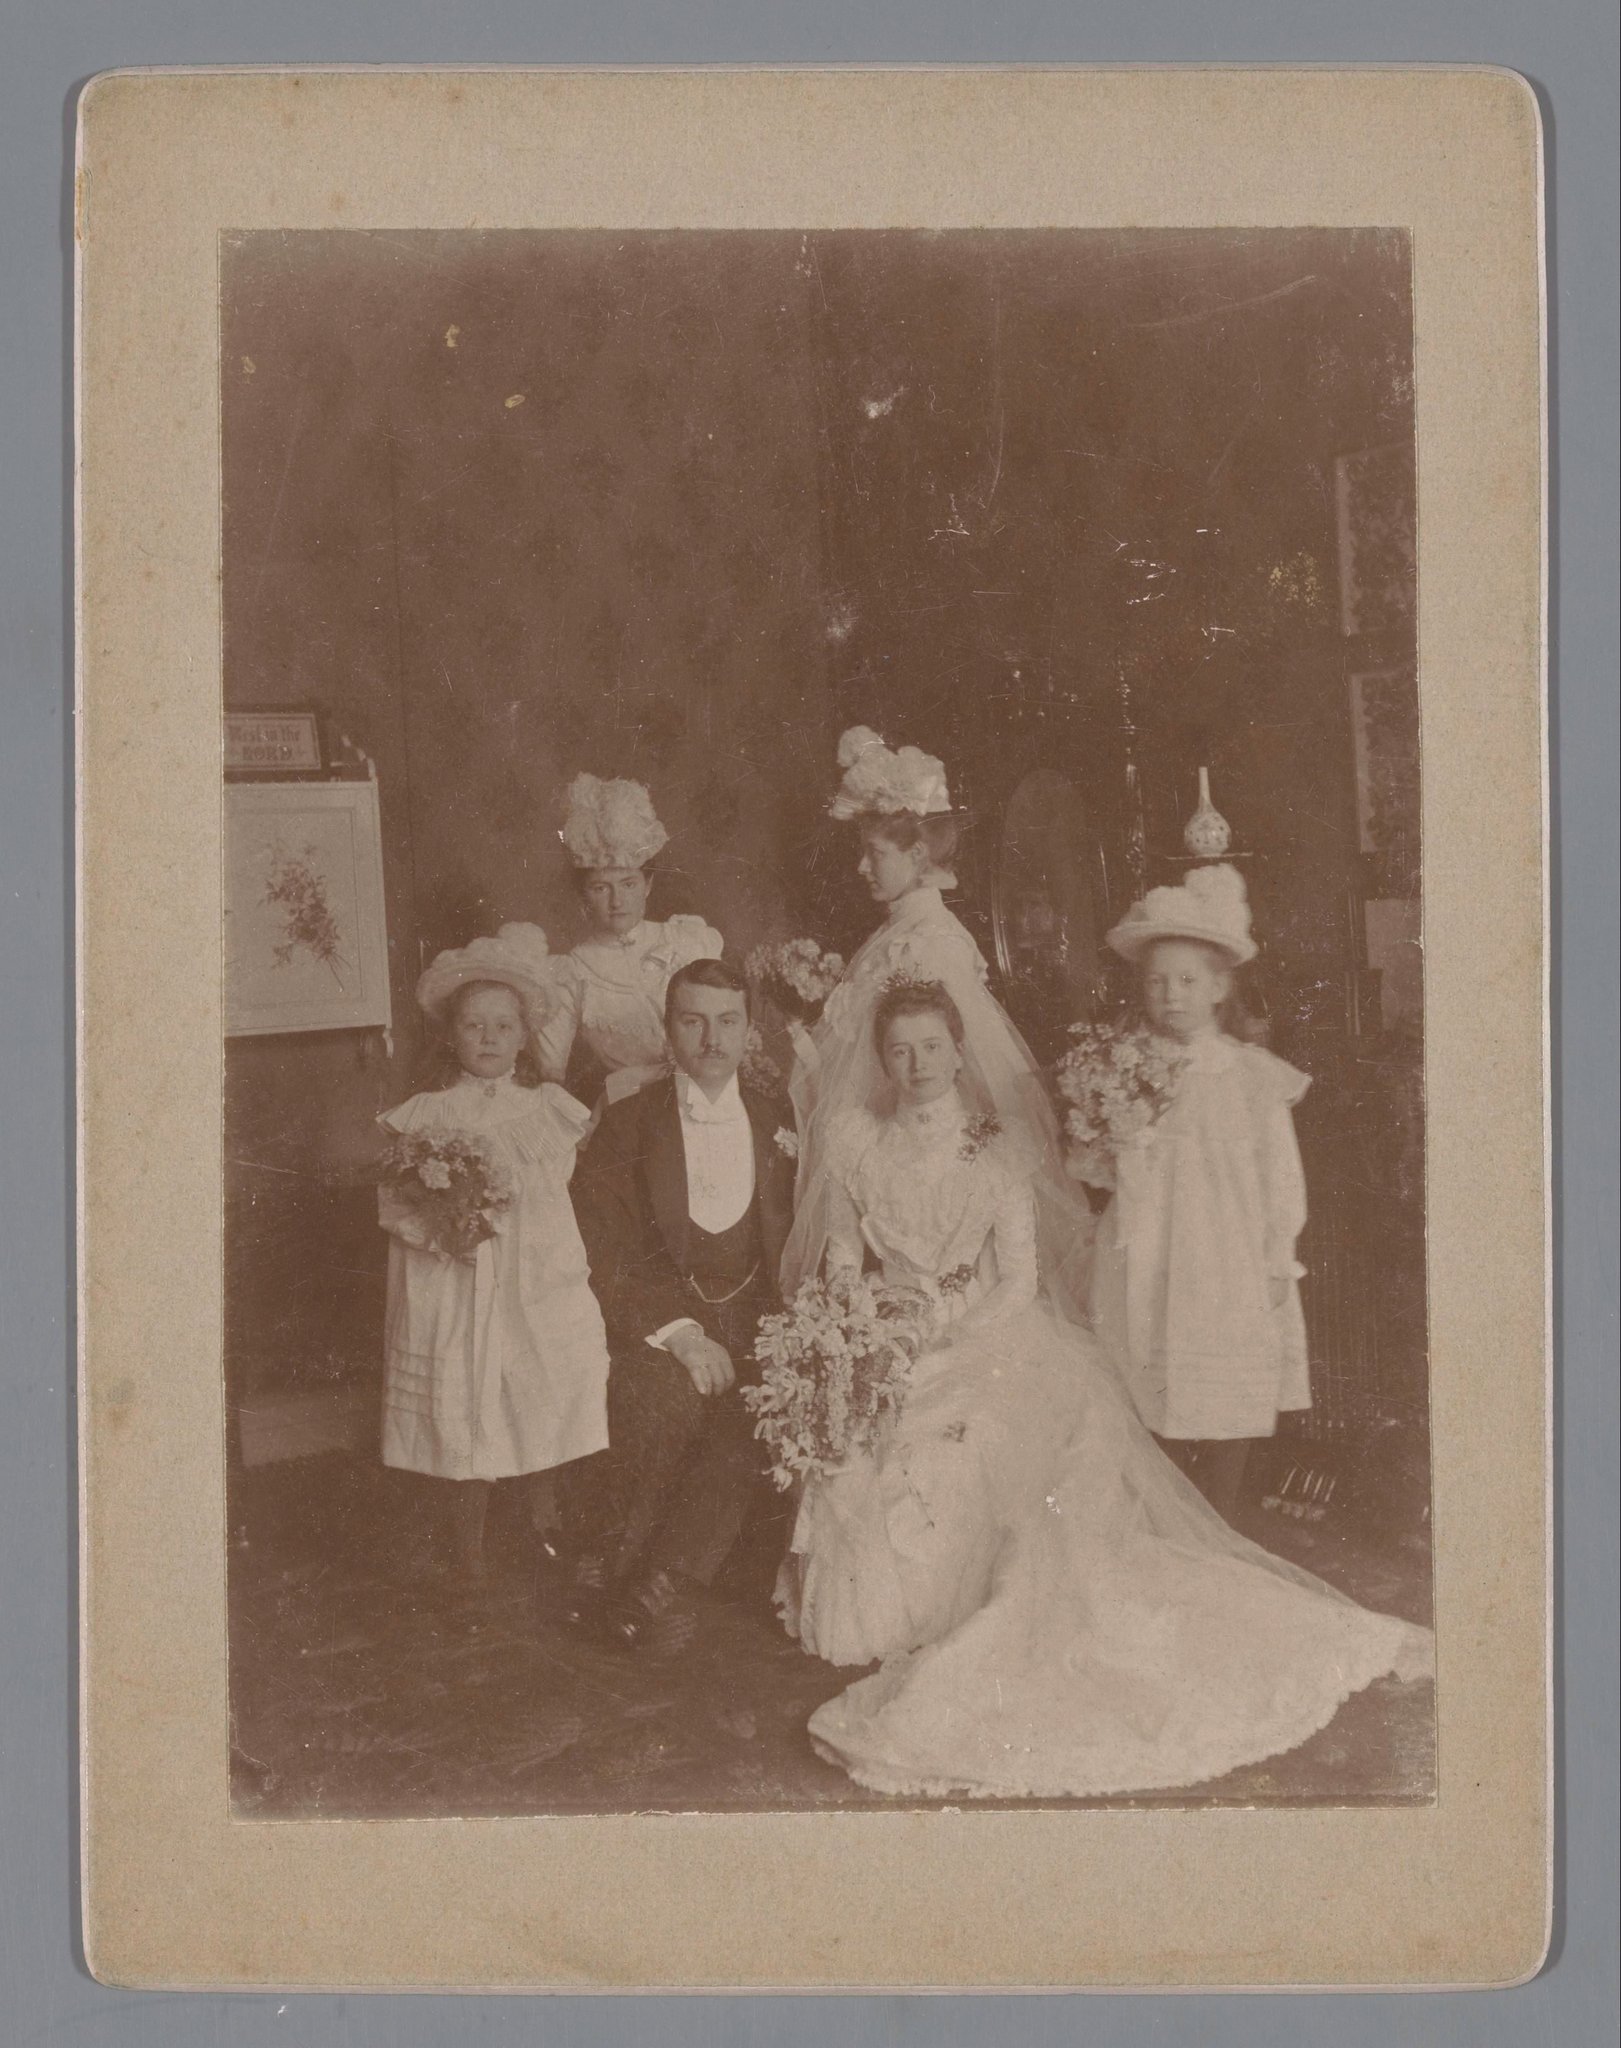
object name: photograph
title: Portret van een onbekend bruidspaar met vier bruidsmeisjes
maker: Anonymous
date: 1880-1910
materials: photographic support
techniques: gelatin silver print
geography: europe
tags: bride and groom in wedding-dress